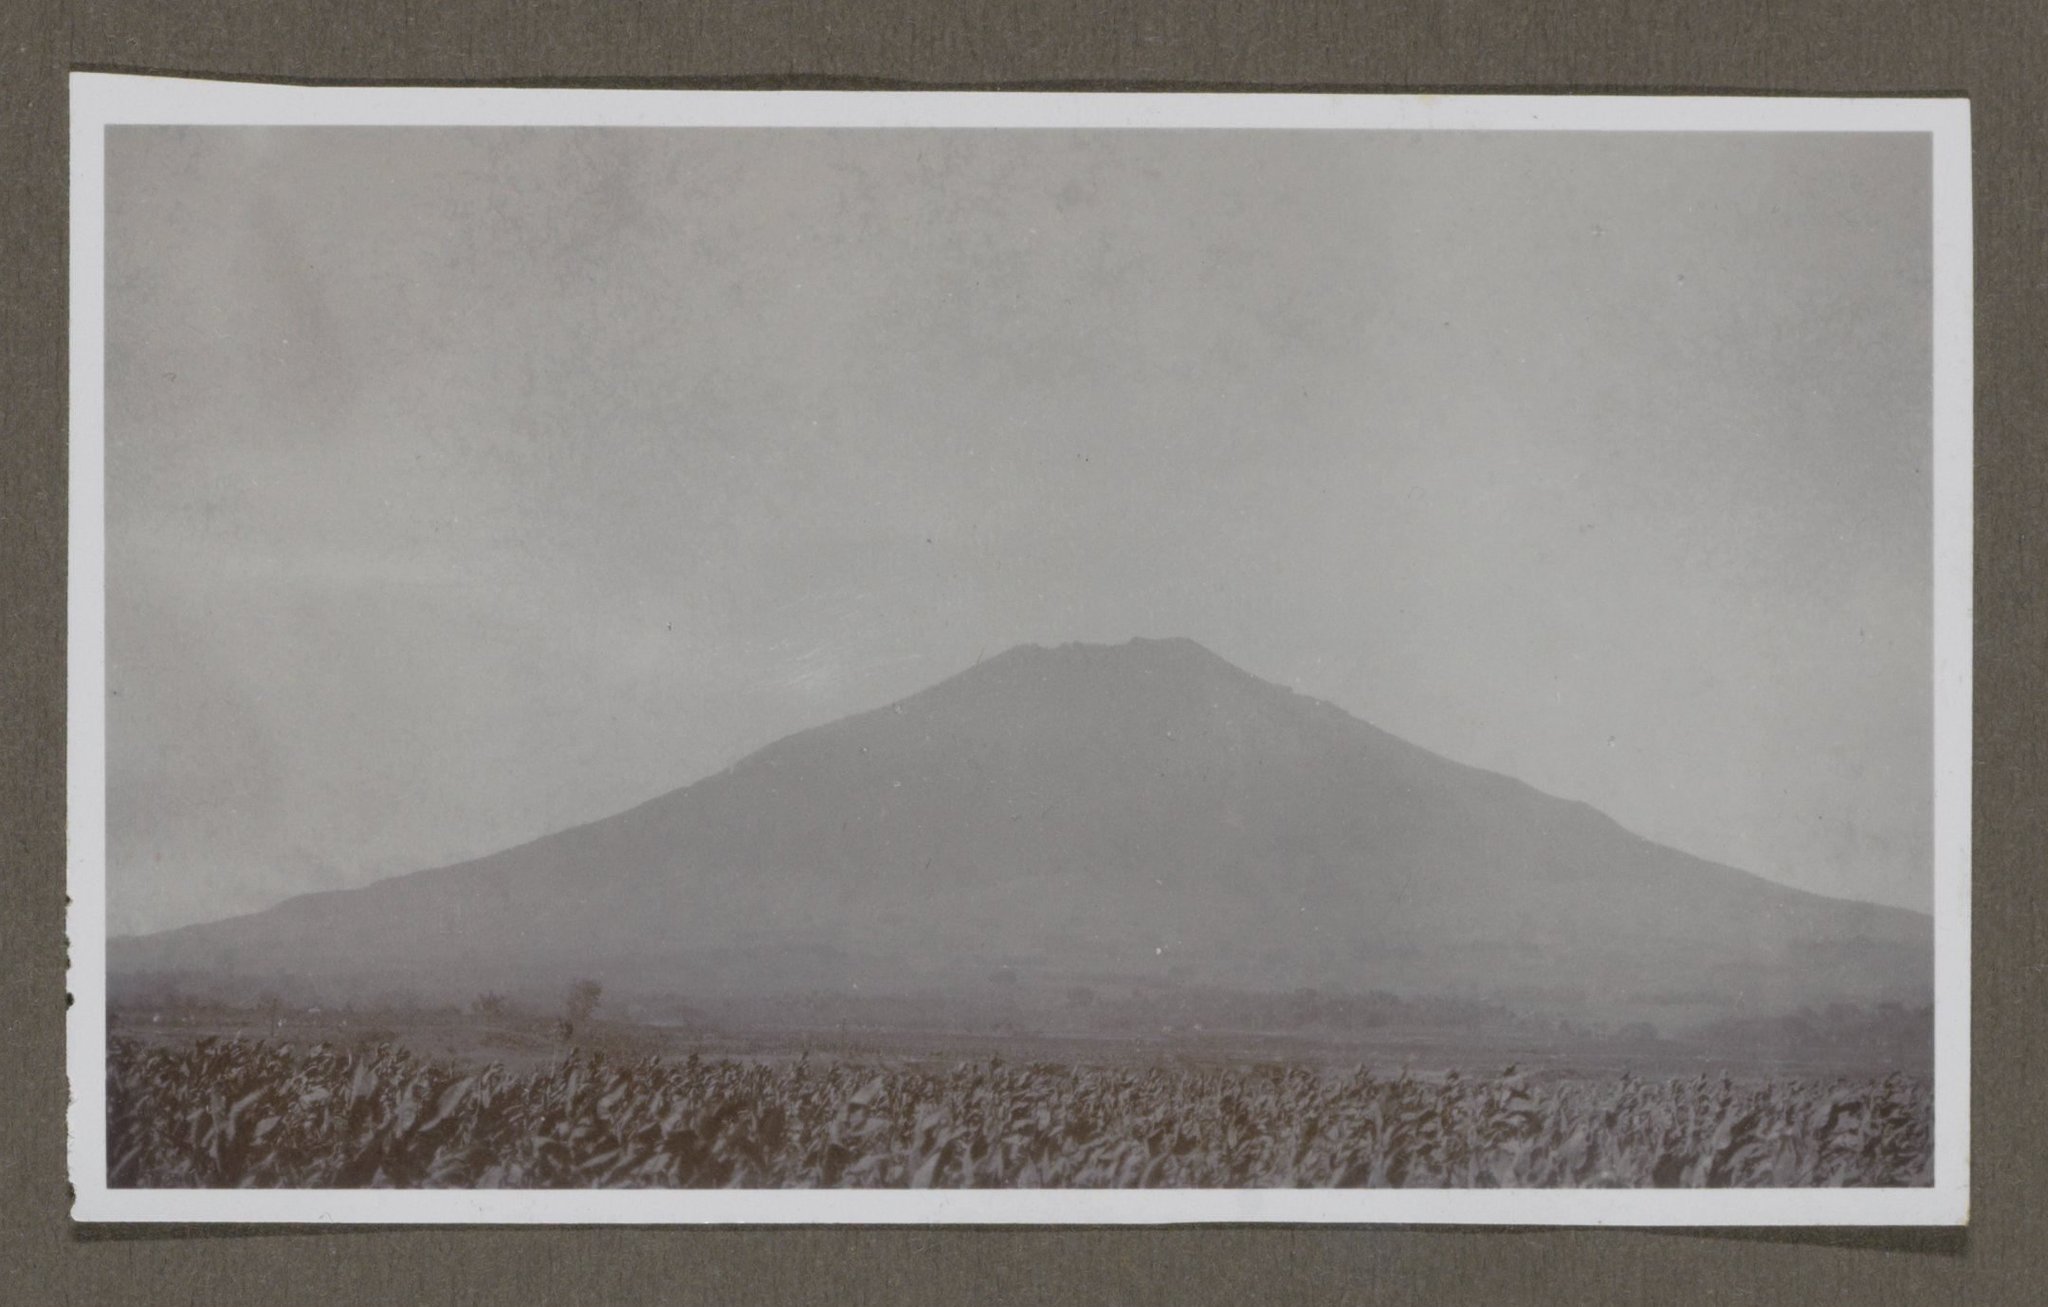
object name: photograph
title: Landschap met een vulkaan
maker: Anonymous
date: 1920-1930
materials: photographic support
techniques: gelatin silver print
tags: volcano, dutch east indies, the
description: Onderdeel van familiealbum Nederlands-Indië.